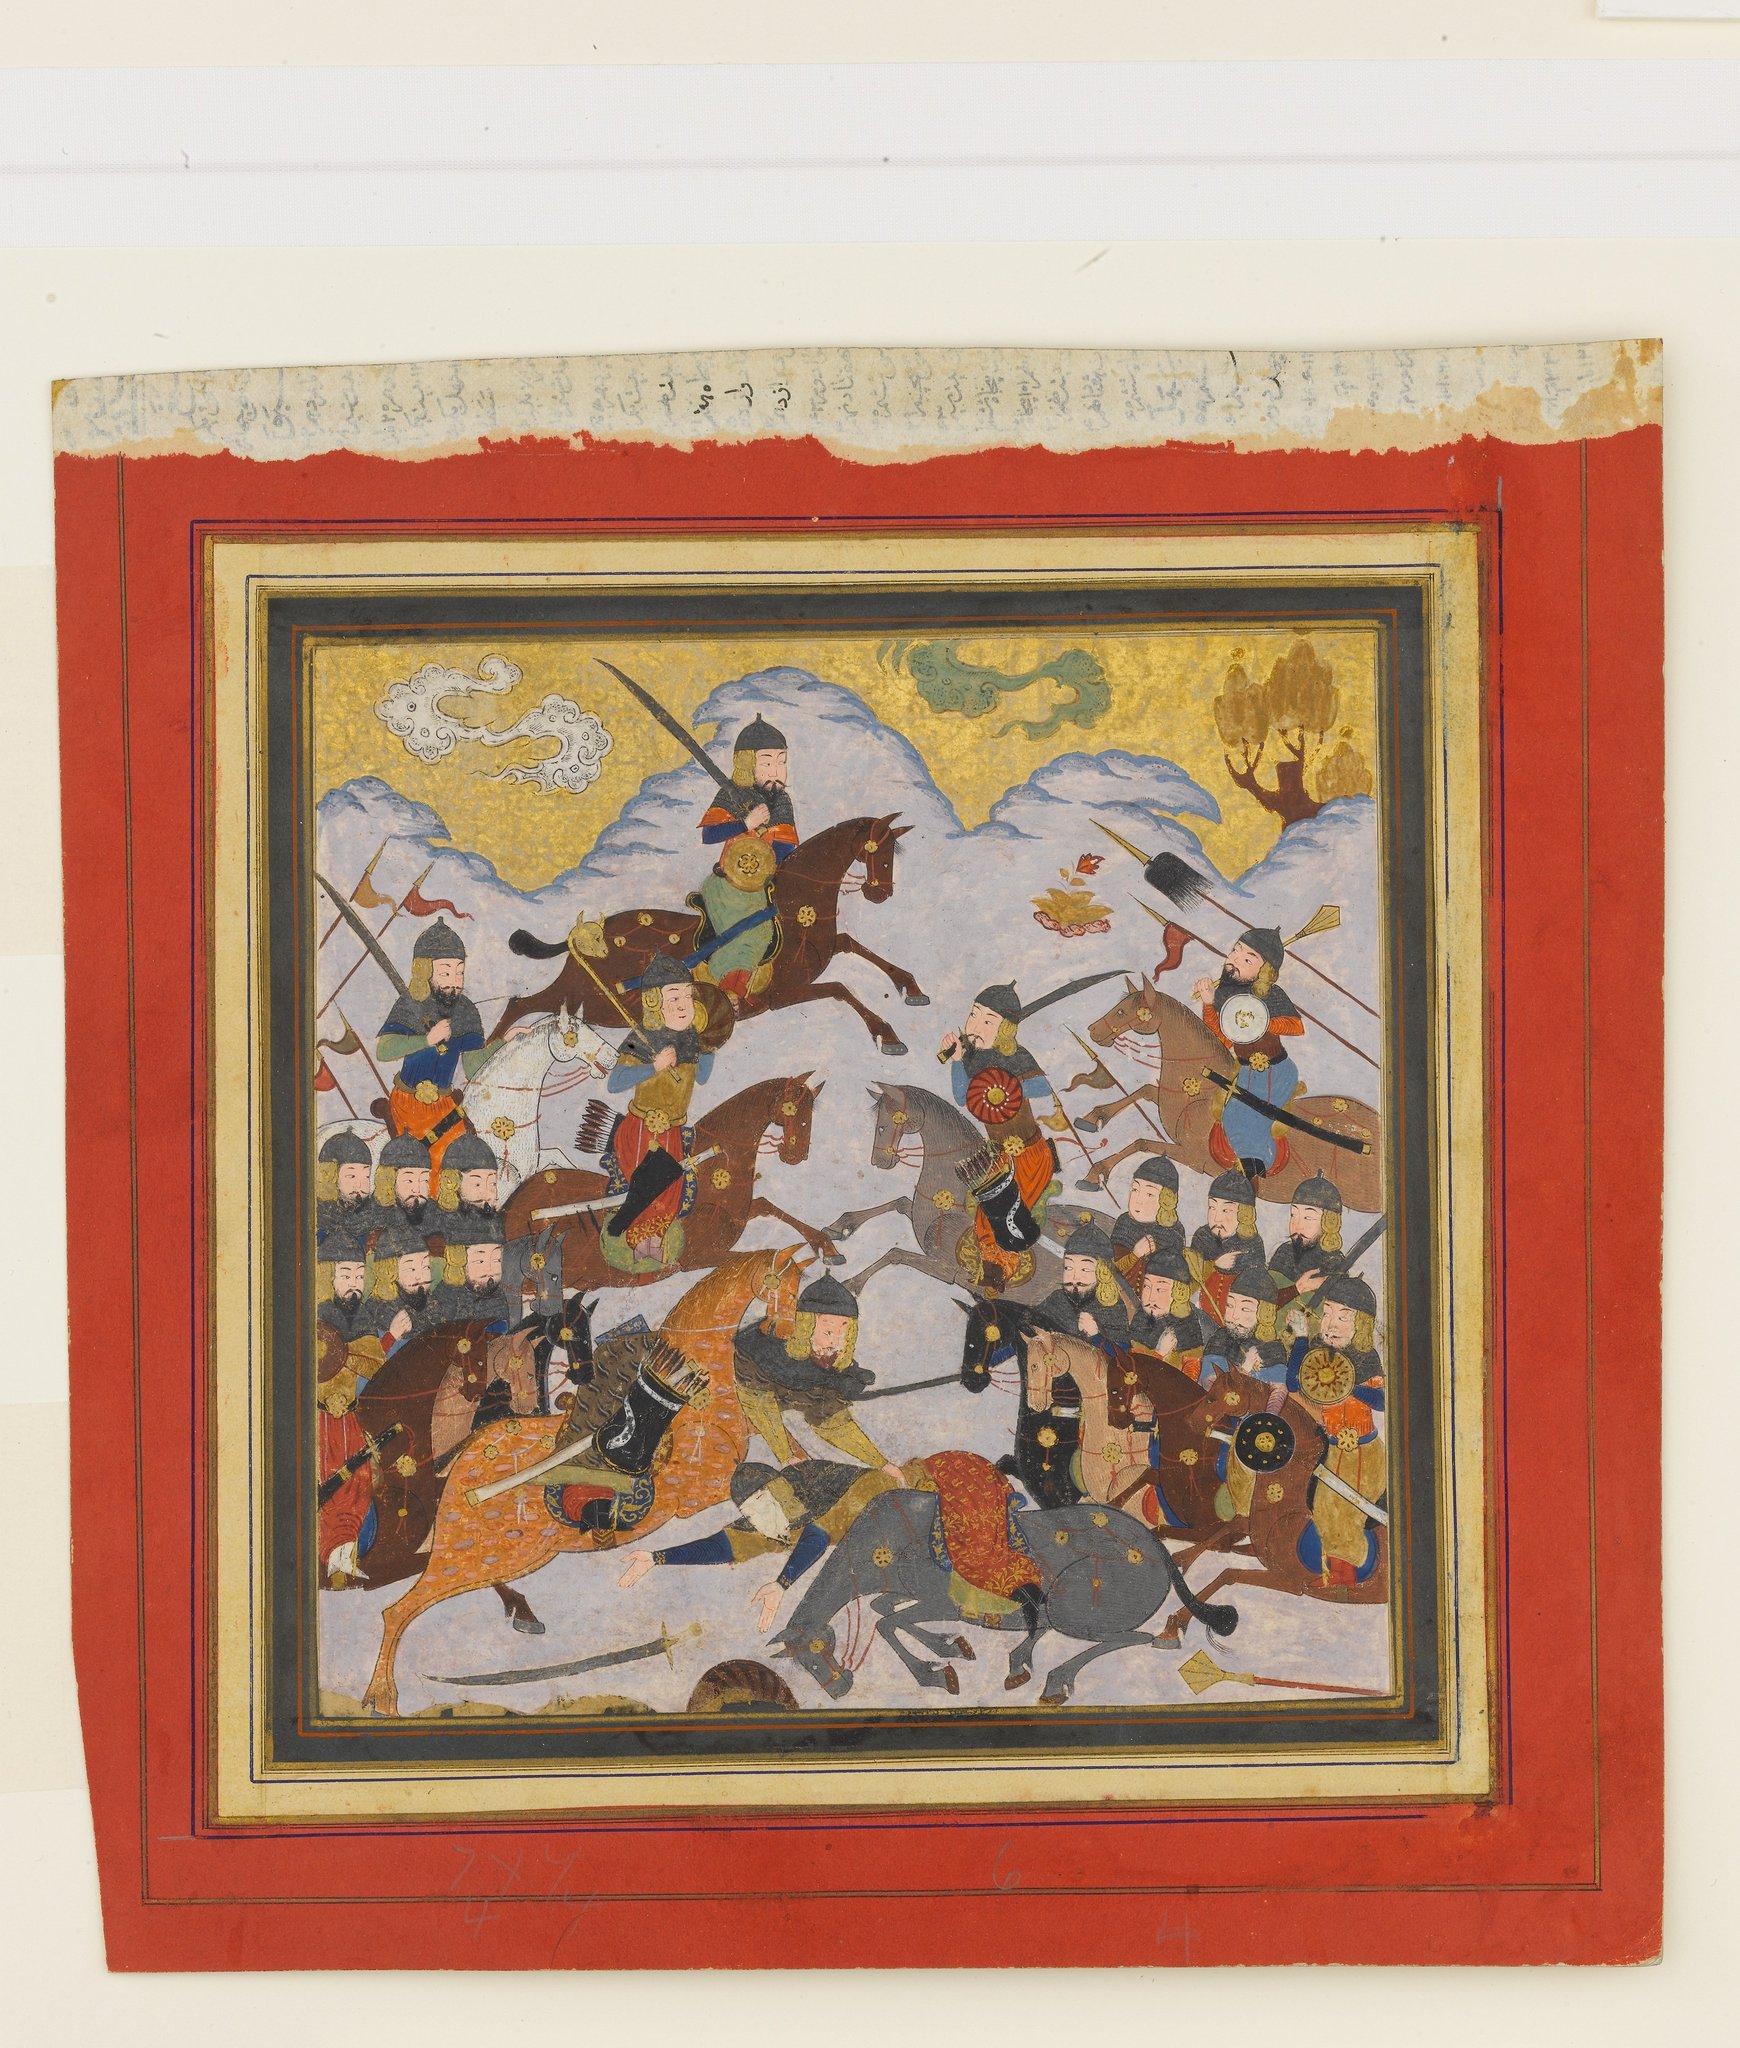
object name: folio from an illustrated manuscript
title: "Rustam Seizes Afrasiyab by the Girdle and Lifts him from the Saddle", Folio from a Shahnama (Book of Kings)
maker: abu'l qasim firdausi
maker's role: author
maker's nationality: iranian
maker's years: 935-1020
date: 1430-1440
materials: gold, ink, paper, watercolor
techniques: dyeing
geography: india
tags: battles,swords,men,horses